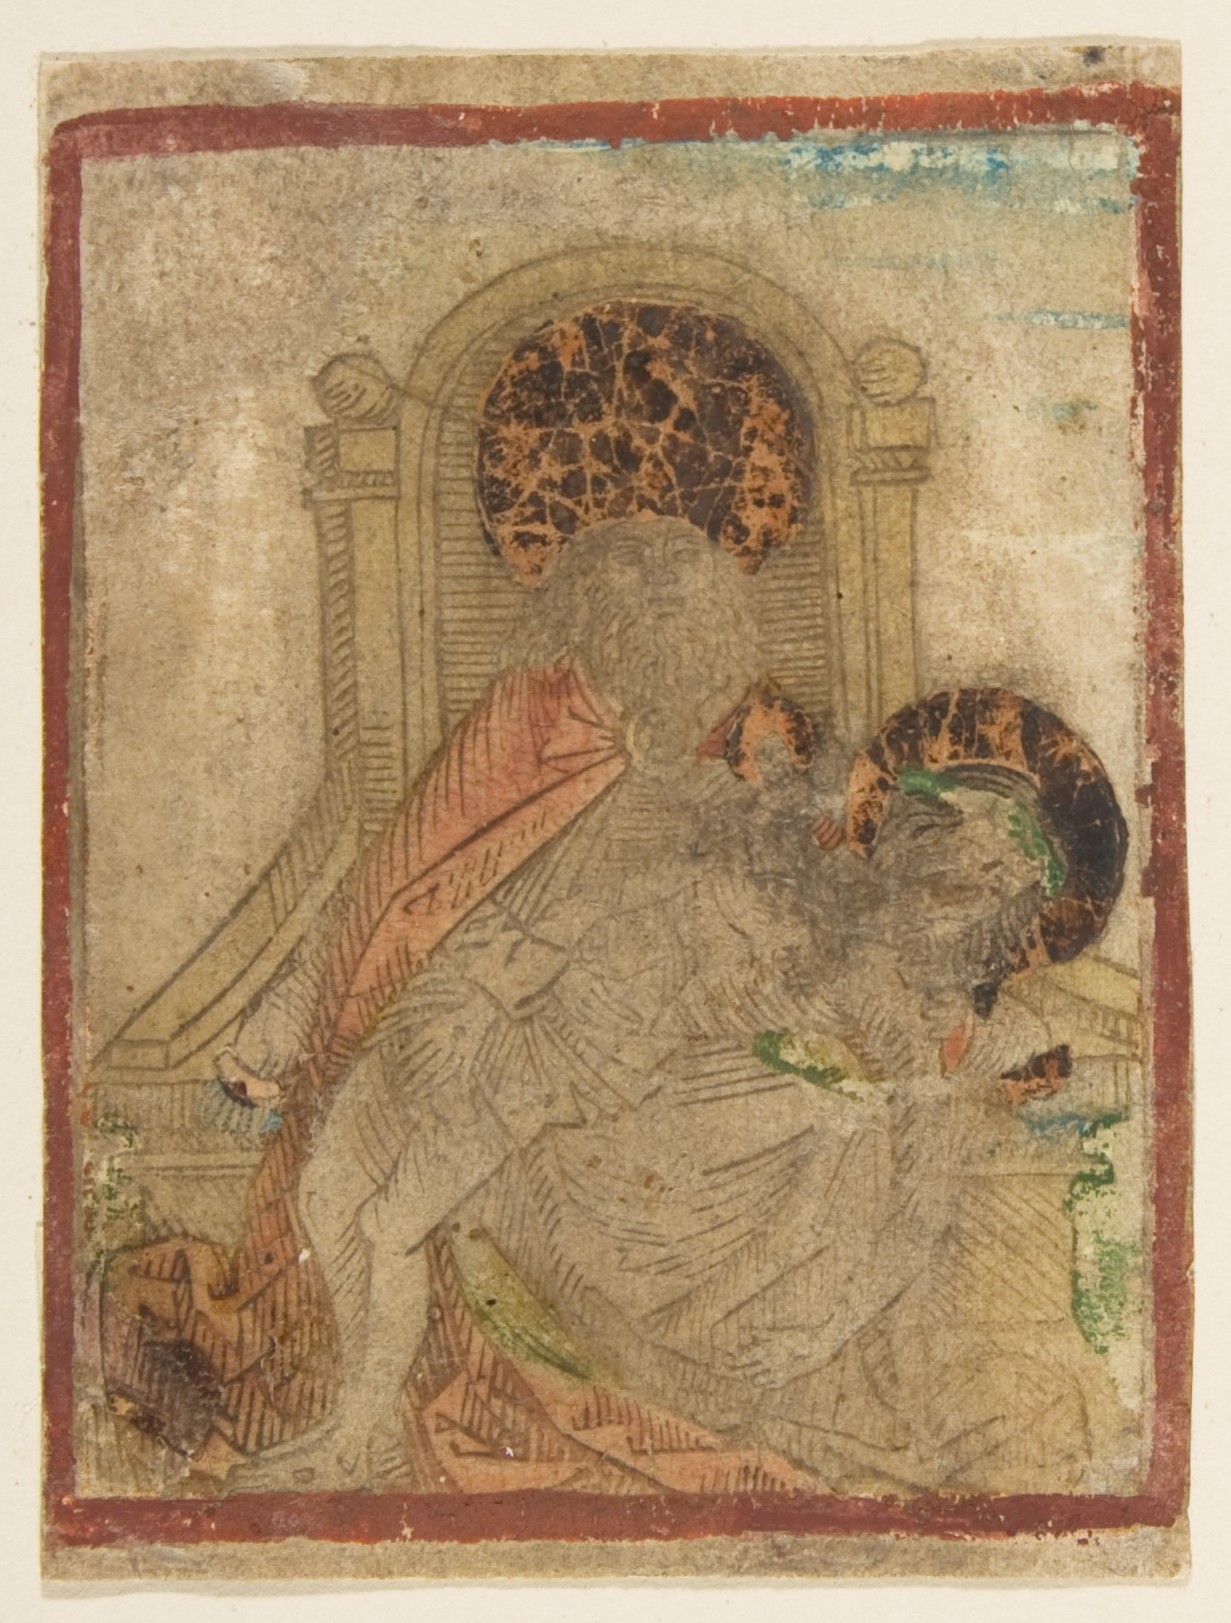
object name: print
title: The Holy Trinity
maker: anonymous, german, 15th century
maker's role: artist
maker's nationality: german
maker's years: 1400-1500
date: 1401-1500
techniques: hand coloring, woodcut